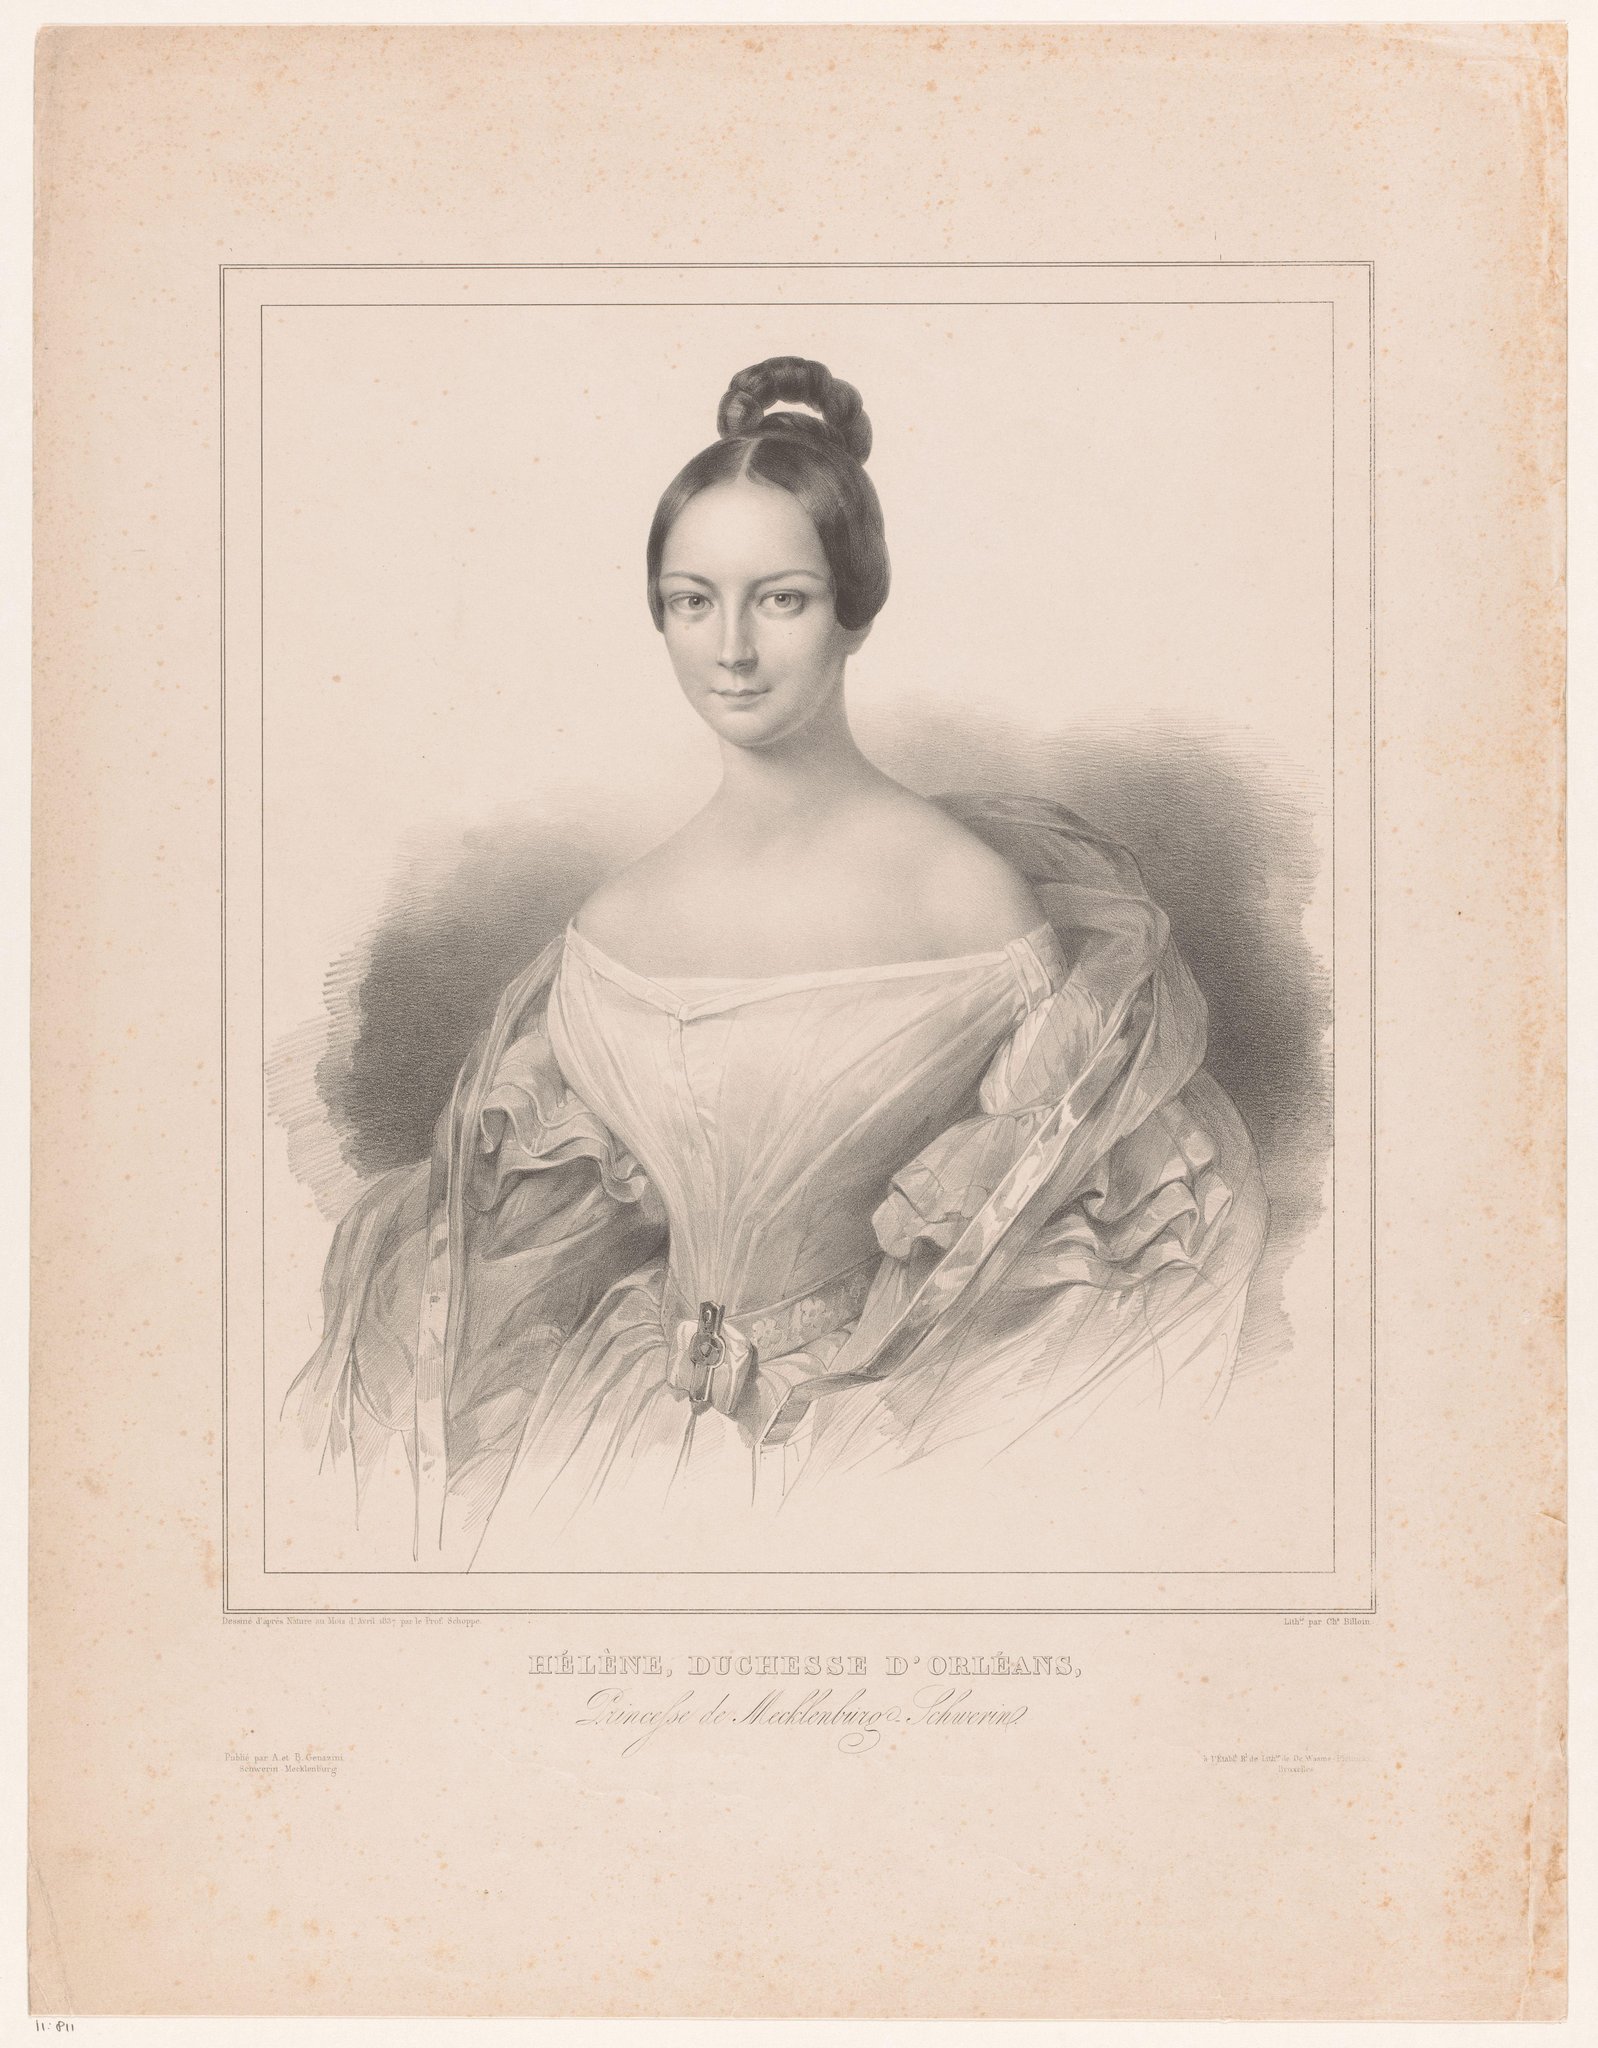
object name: print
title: Portret van Helene van Mecklenburg-Schwerin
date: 1823-1869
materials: paper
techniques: lithograph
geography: brussels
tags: helene van mecklenburg-schwerin, adult woman, historical persons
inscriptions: collector's mark: Lugt 2228